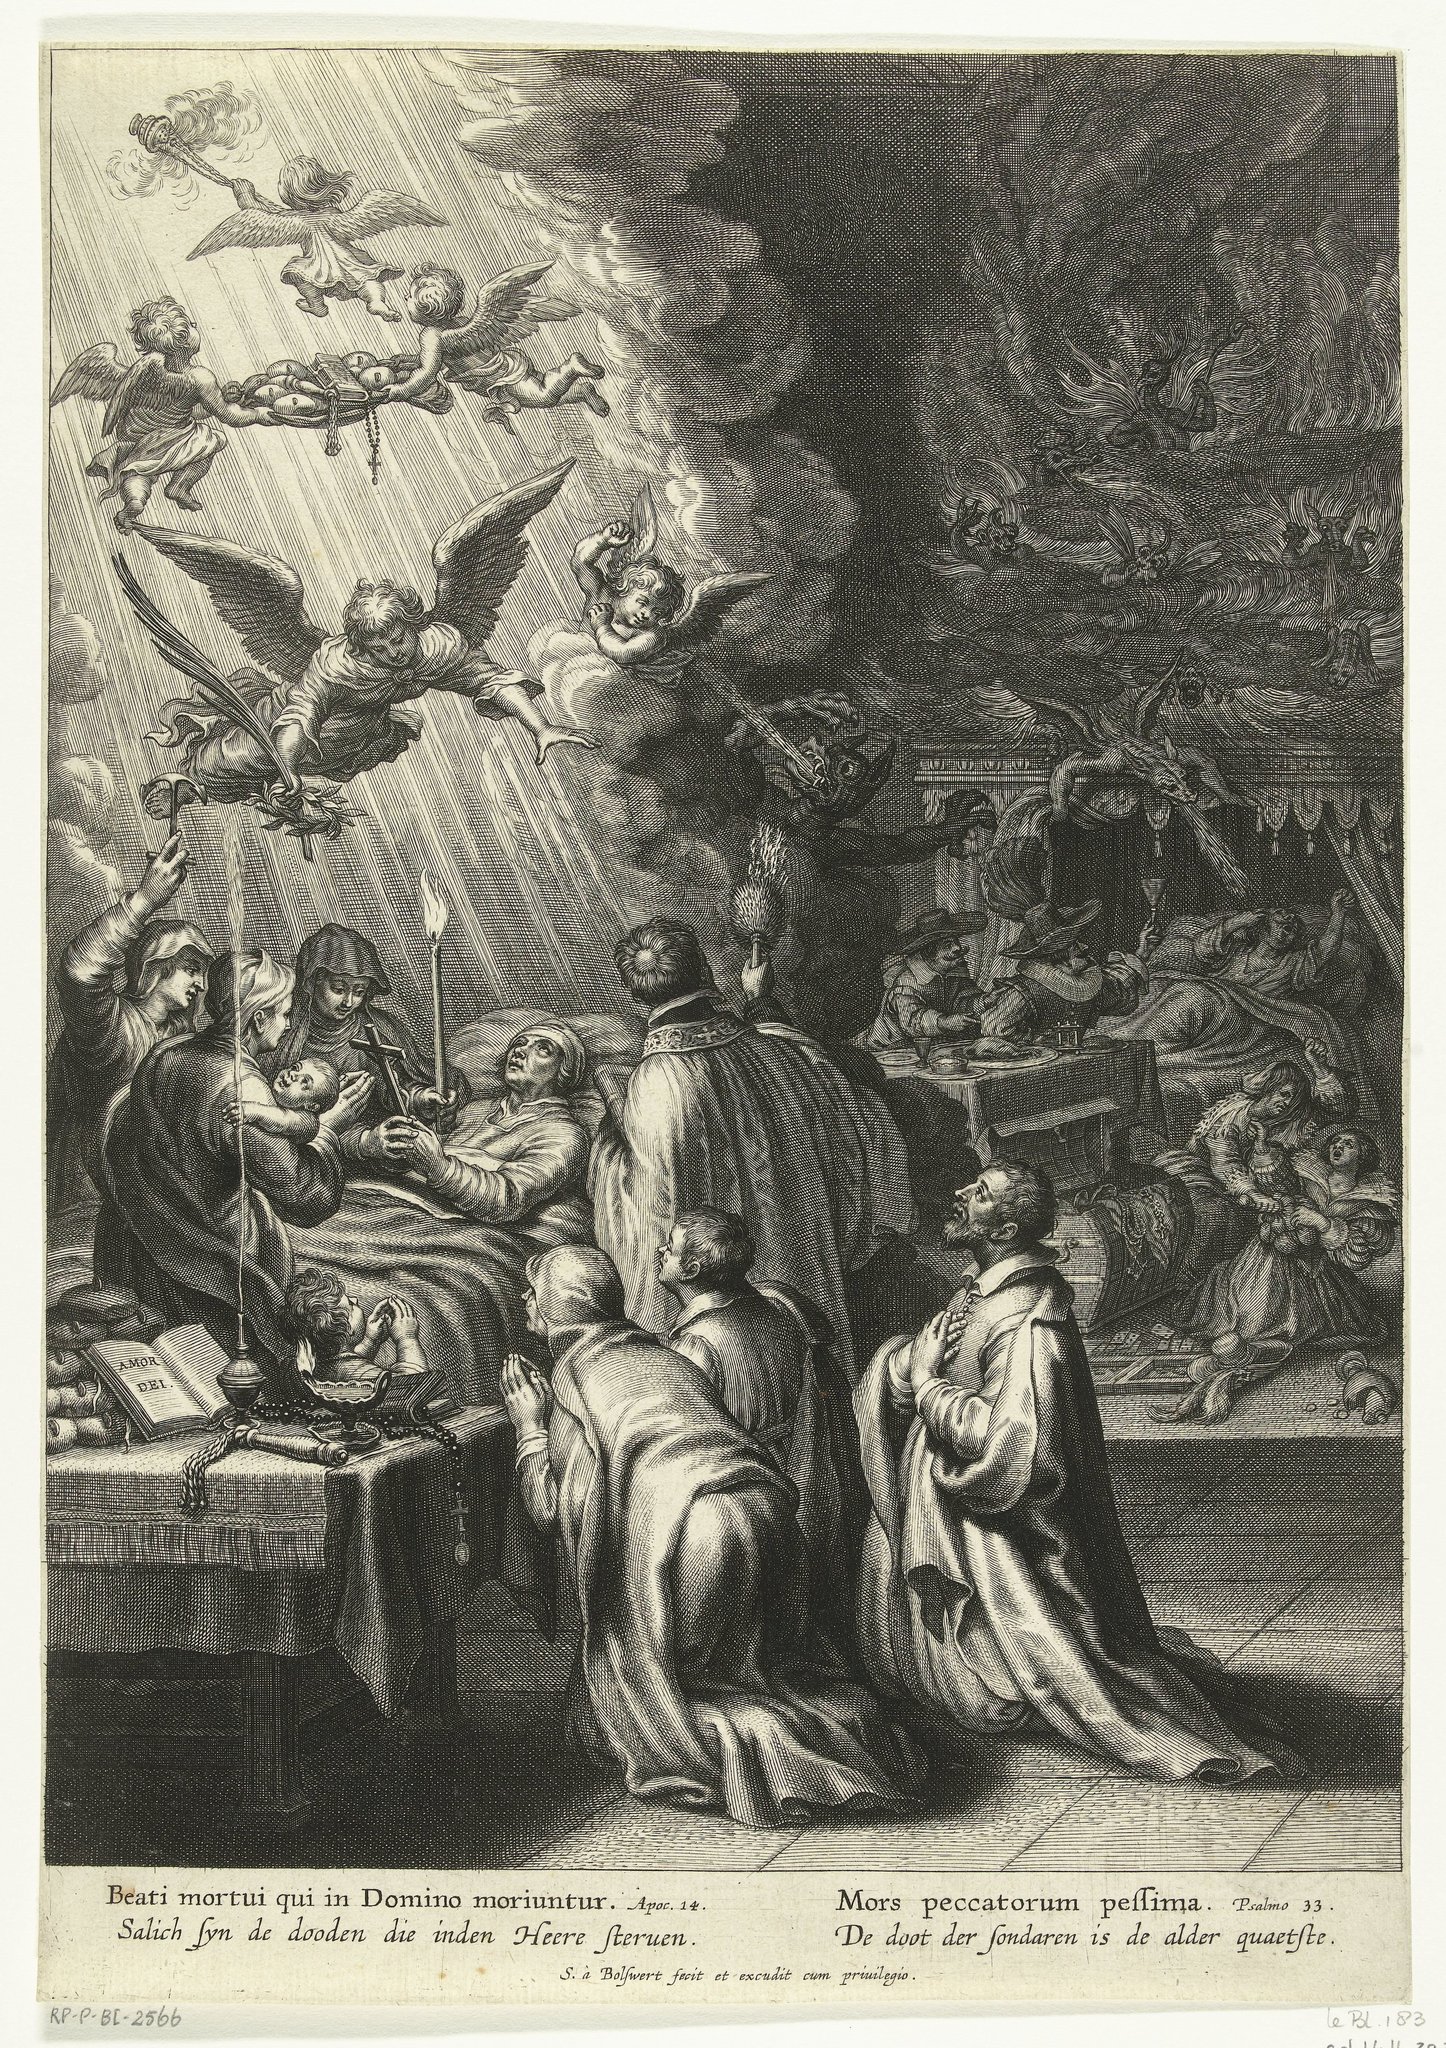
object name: print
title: Allegorie op het sterven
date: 1596-1659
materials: paper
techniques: engraving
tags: hell and purgatory, dying, the blessed are brought to heaven ~ last judgement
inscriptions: collector's mark: Lugt 240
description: Allegorie op het sterven met stervende vrouw bijgestaan door geestelijken en treurende familie, zij is welkom in de hemel. Op een tafel ligt een opengeslagen boek met de tekst Amor Dei. Op de achtergrond in het donker zitten mannen en vrouwen die zich schuldig maken aan teveel eten en drinken en hechten aan kostbare bezittingen zoals juwelen. Op de grond liggen sporen van verderflijke activiteiten zoals een kaartspel en een bordspel. Zij zien achter zich wat er met hen gebeurt als zij dood gaan: de ziel van een vrouw in bed wordt gehaald door de duivel en demonen wachten in het vagevuur. Onder de voorstelling staan citaten uit de bijbelteksten Apocalyps 14 en Psalmen 33.